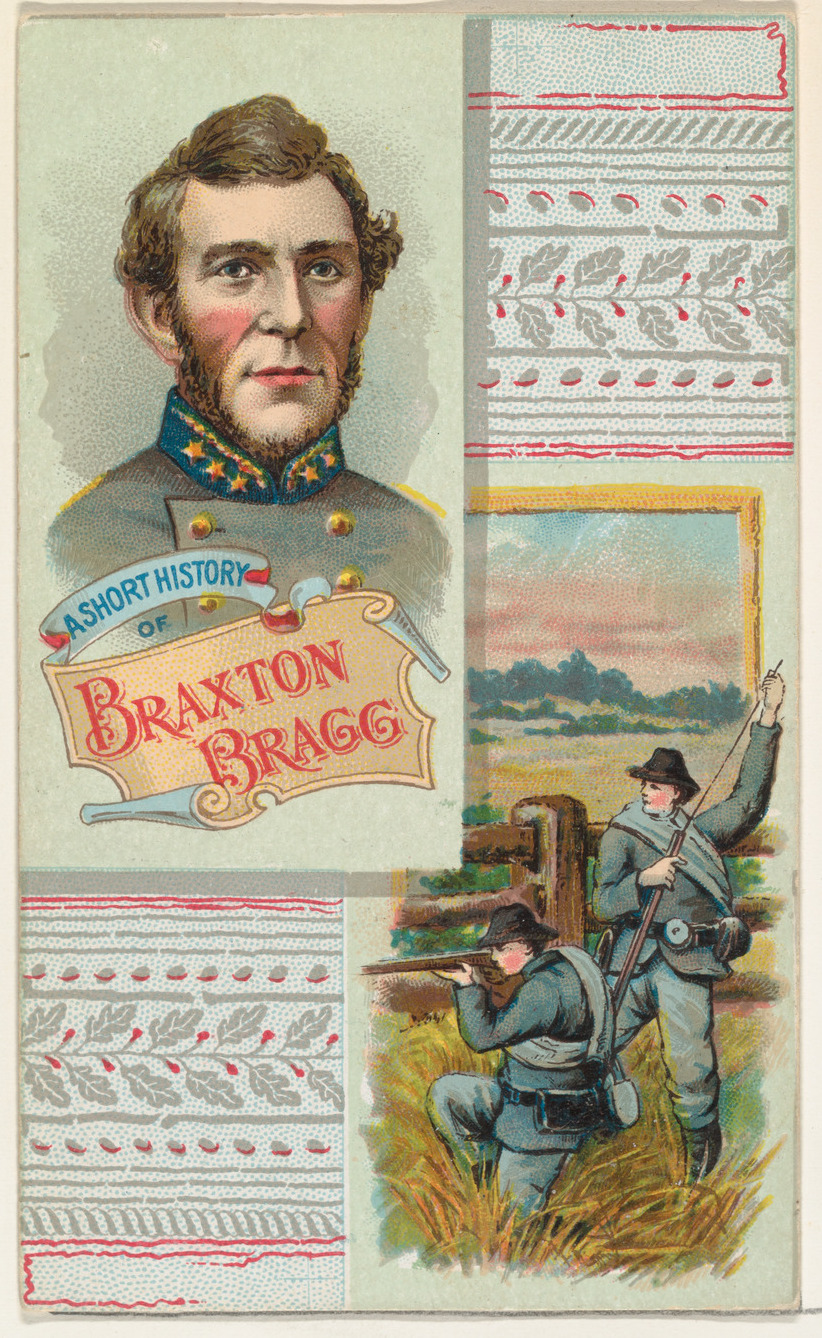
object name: print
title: A Short History of General Braxton Bragg, from the Histories of Generals series (N114) issued by W. Duke, Sons & Co. to promote Honest Long Cut Smoking and Chewing Tobacco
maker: w. duke, sons & co.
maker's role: publisher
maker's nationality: american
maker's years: 1870-1920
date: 1888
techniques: color lithograph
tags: men,portraits,generals